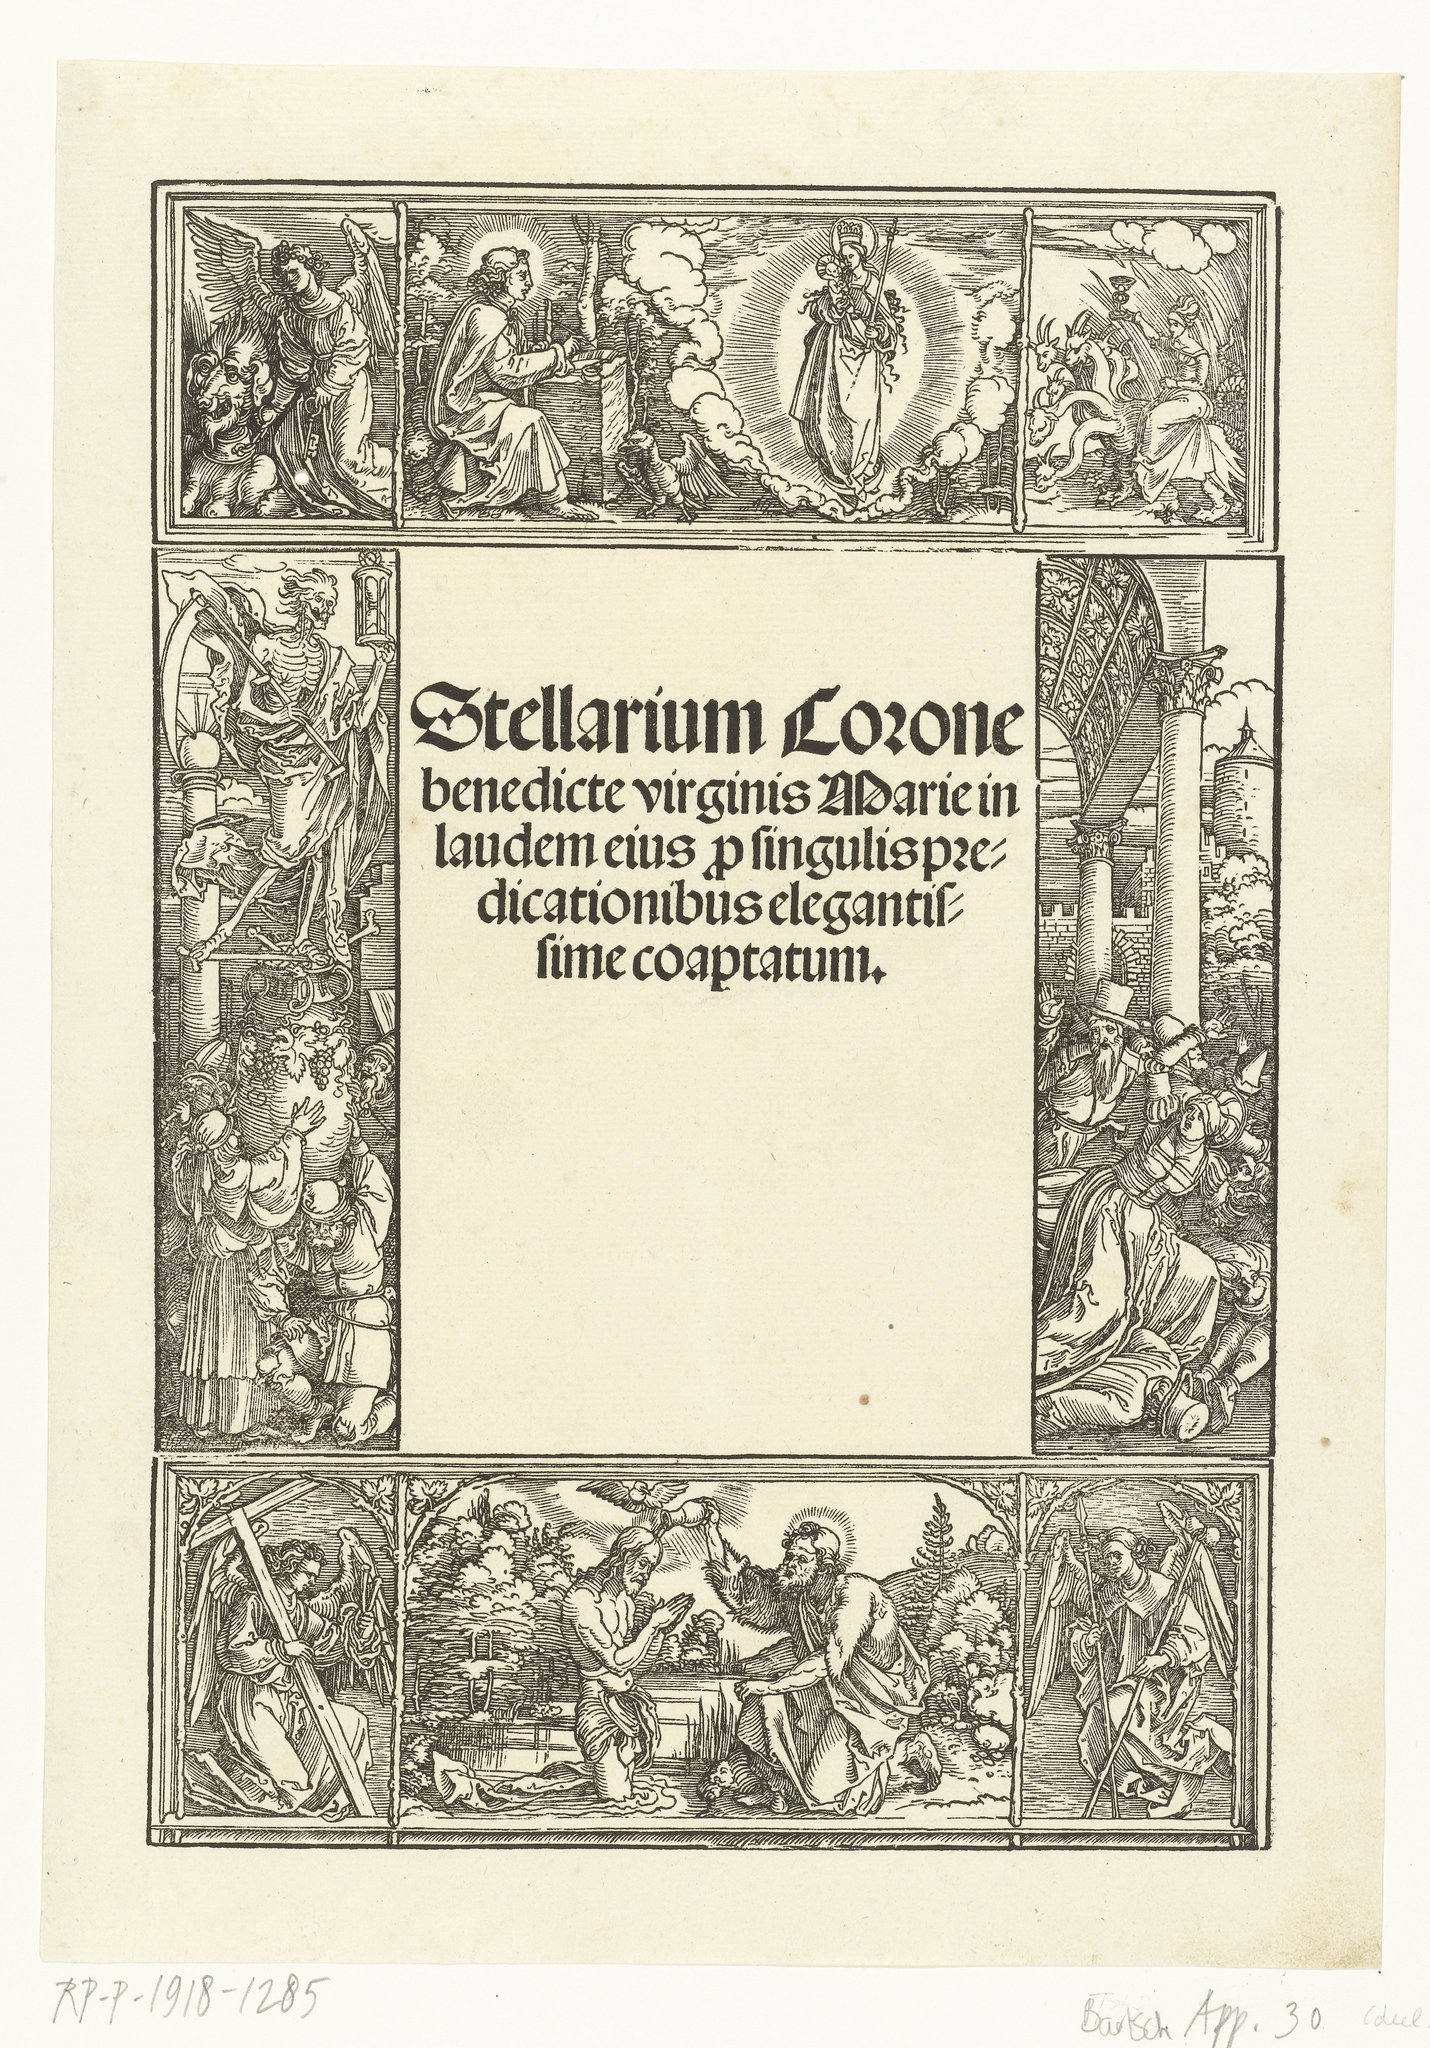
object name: print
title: Stellarium Corone (...)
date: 1500-1517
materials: paper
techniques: woodcut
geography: nuremberg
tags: baptism of christ in the river jordan: john the baptist pouring out water on christ's head: the holy ghost descends, john (writing) on the island of patmos, possibly the eagle beside him, death as skeleton, the scarlet woman, the whore of babylon; she is usually sitting on a scarlet beast with seven heads and ten horns, the instruments of the passion and the five wounded limbs, st. john the evangelist writing the gospel, usually the eagle present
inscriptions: collector's mark: Lugt 2926, collector's mark: Lugt 2233